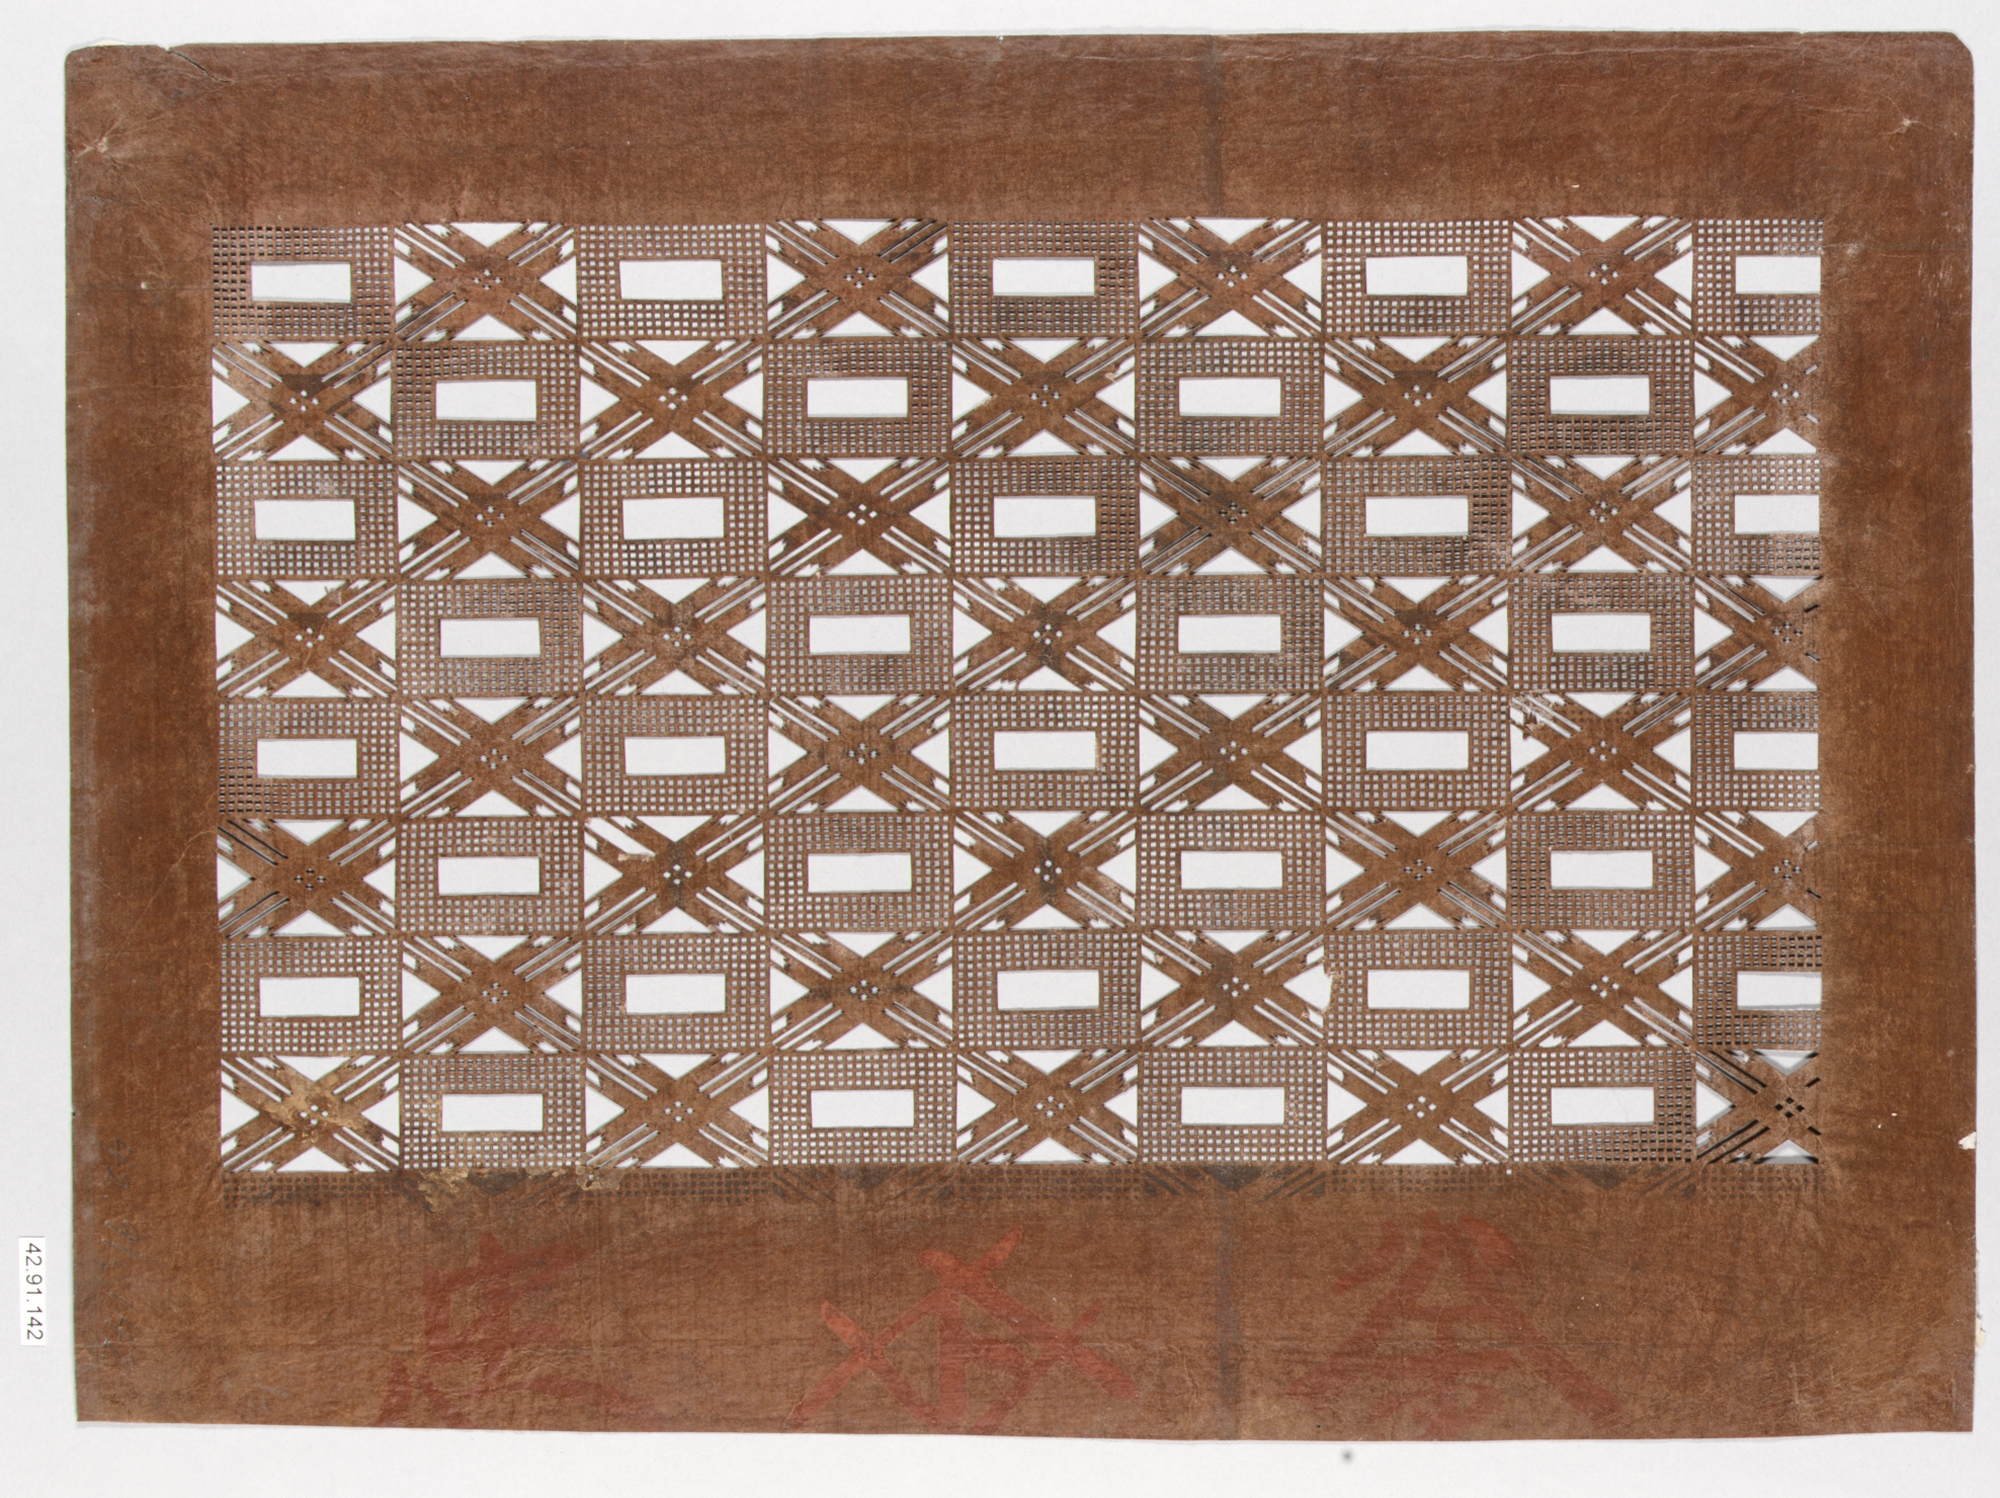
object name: stencil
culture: japanese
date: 1801-1900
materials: paper